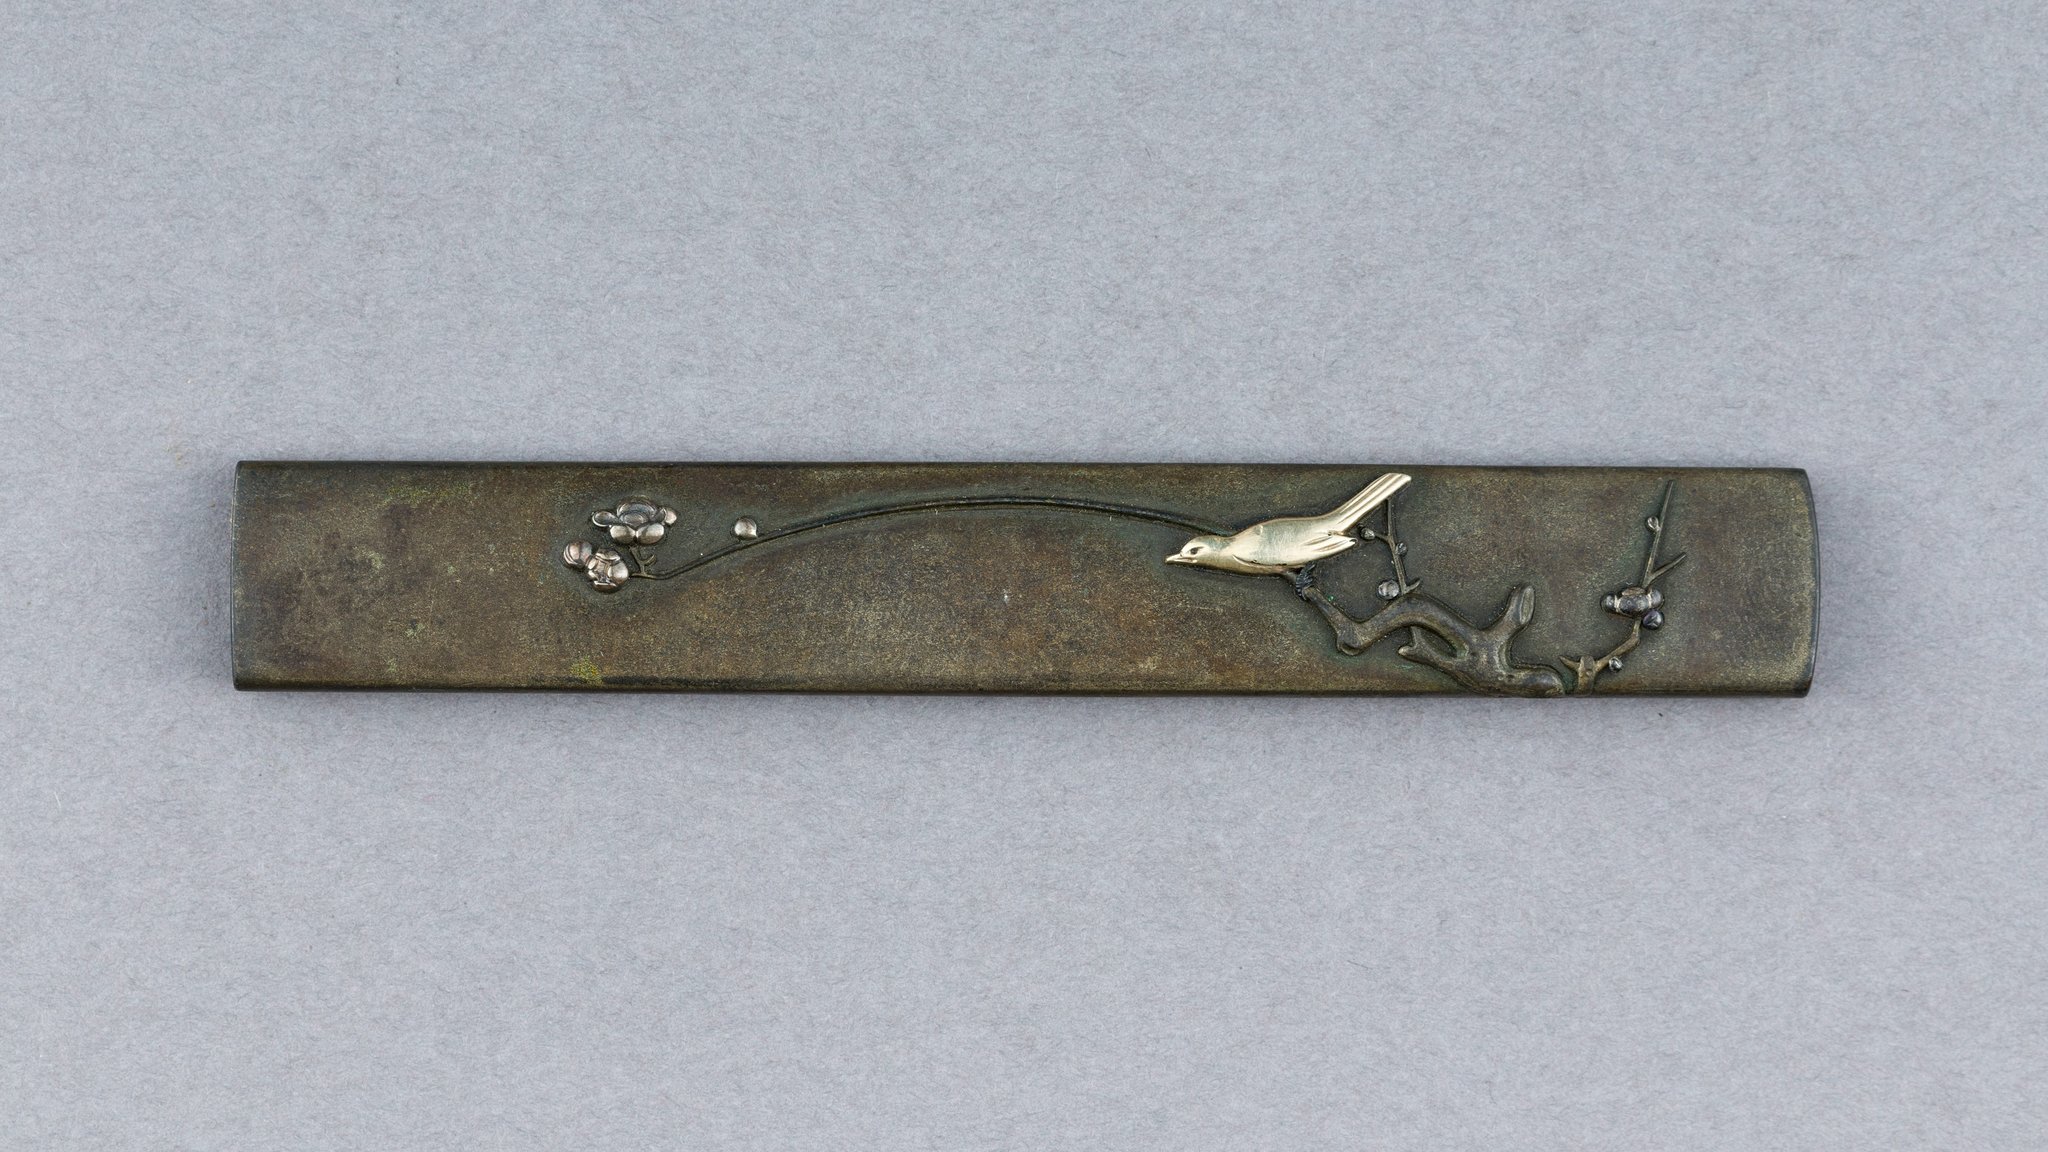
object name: knife handle kozuka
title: Knife Handle (Kozuka)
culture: japanese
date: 1615-1868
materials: silver alloy, gold, silver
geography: japan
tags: birds